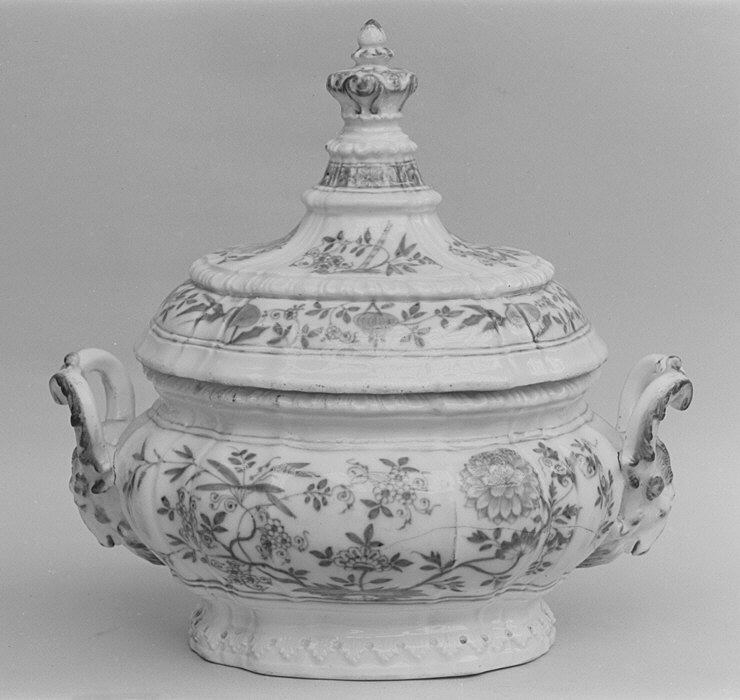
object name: tureen with cover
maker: meissen manufactory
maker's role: manufactory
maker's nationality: german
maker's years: 1710-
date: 1735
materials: hard paste porcelain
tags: flowers